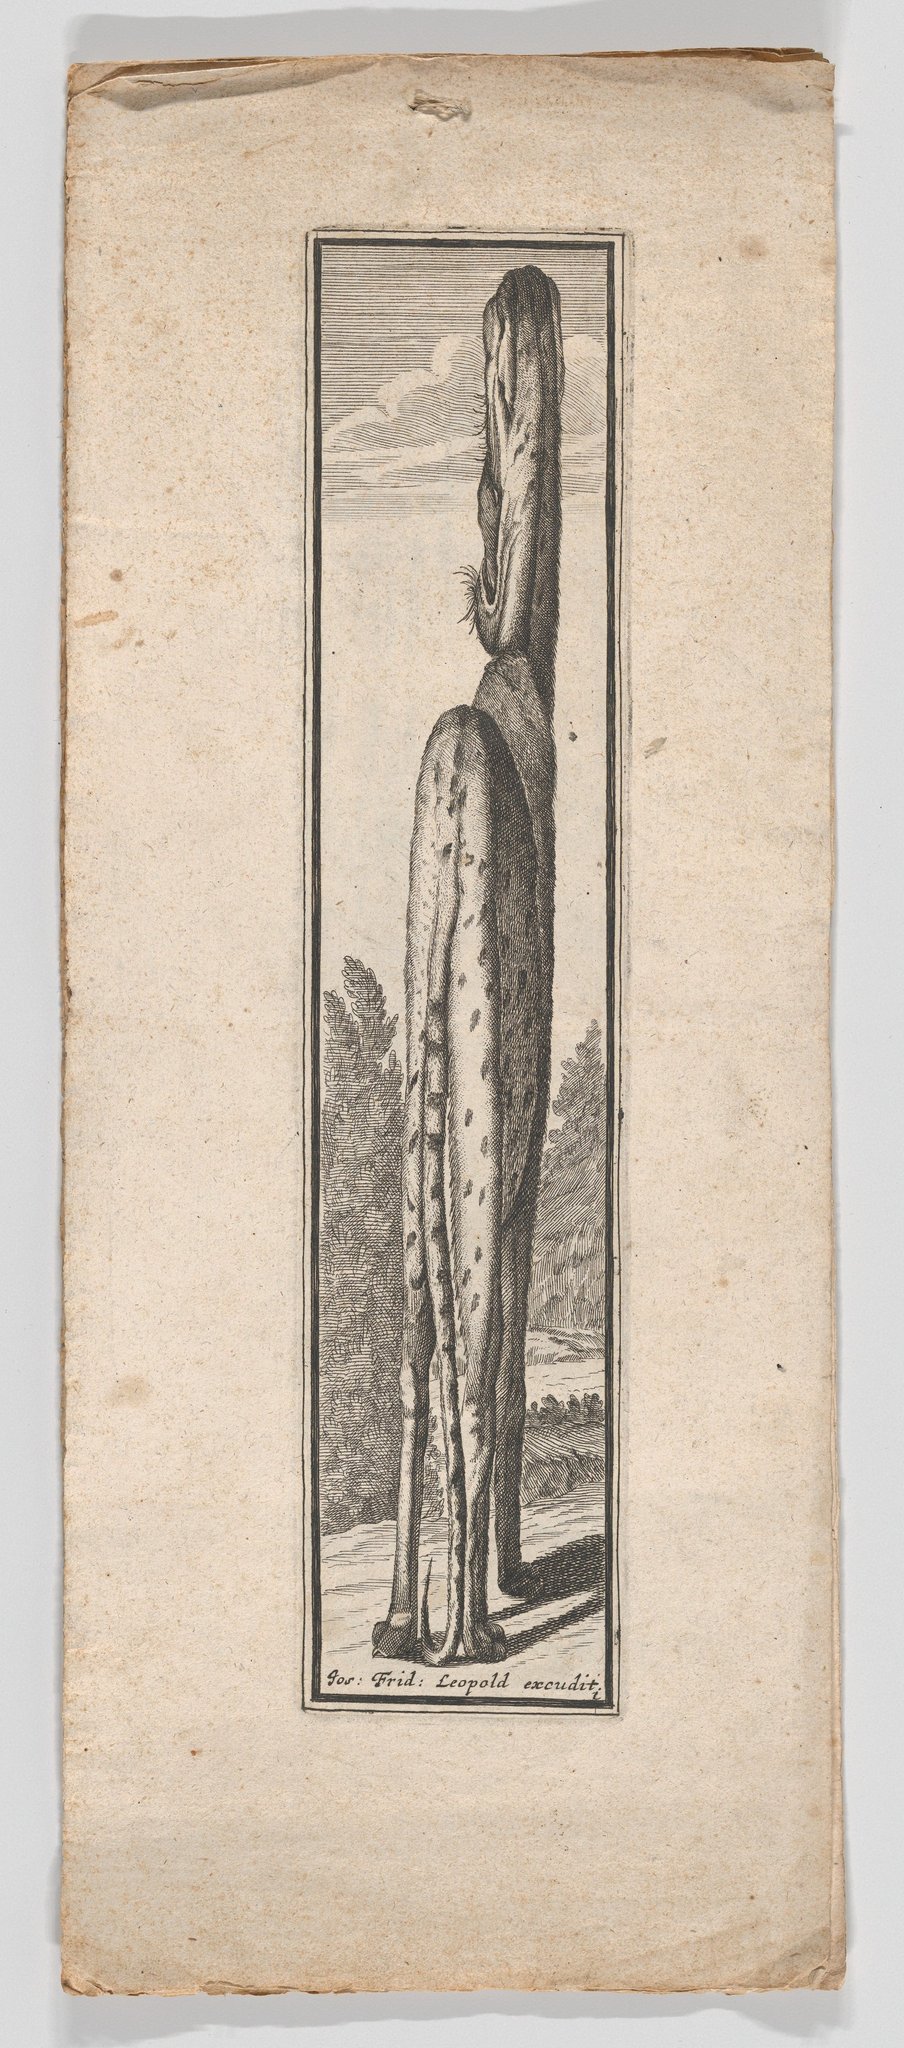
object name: print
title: Series of Six Anamorphic Animal Prints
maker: joseph friedrich leopold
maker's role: print maker, publisher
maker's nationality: german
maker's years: 1668-1726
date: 1700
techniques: etching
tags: animals